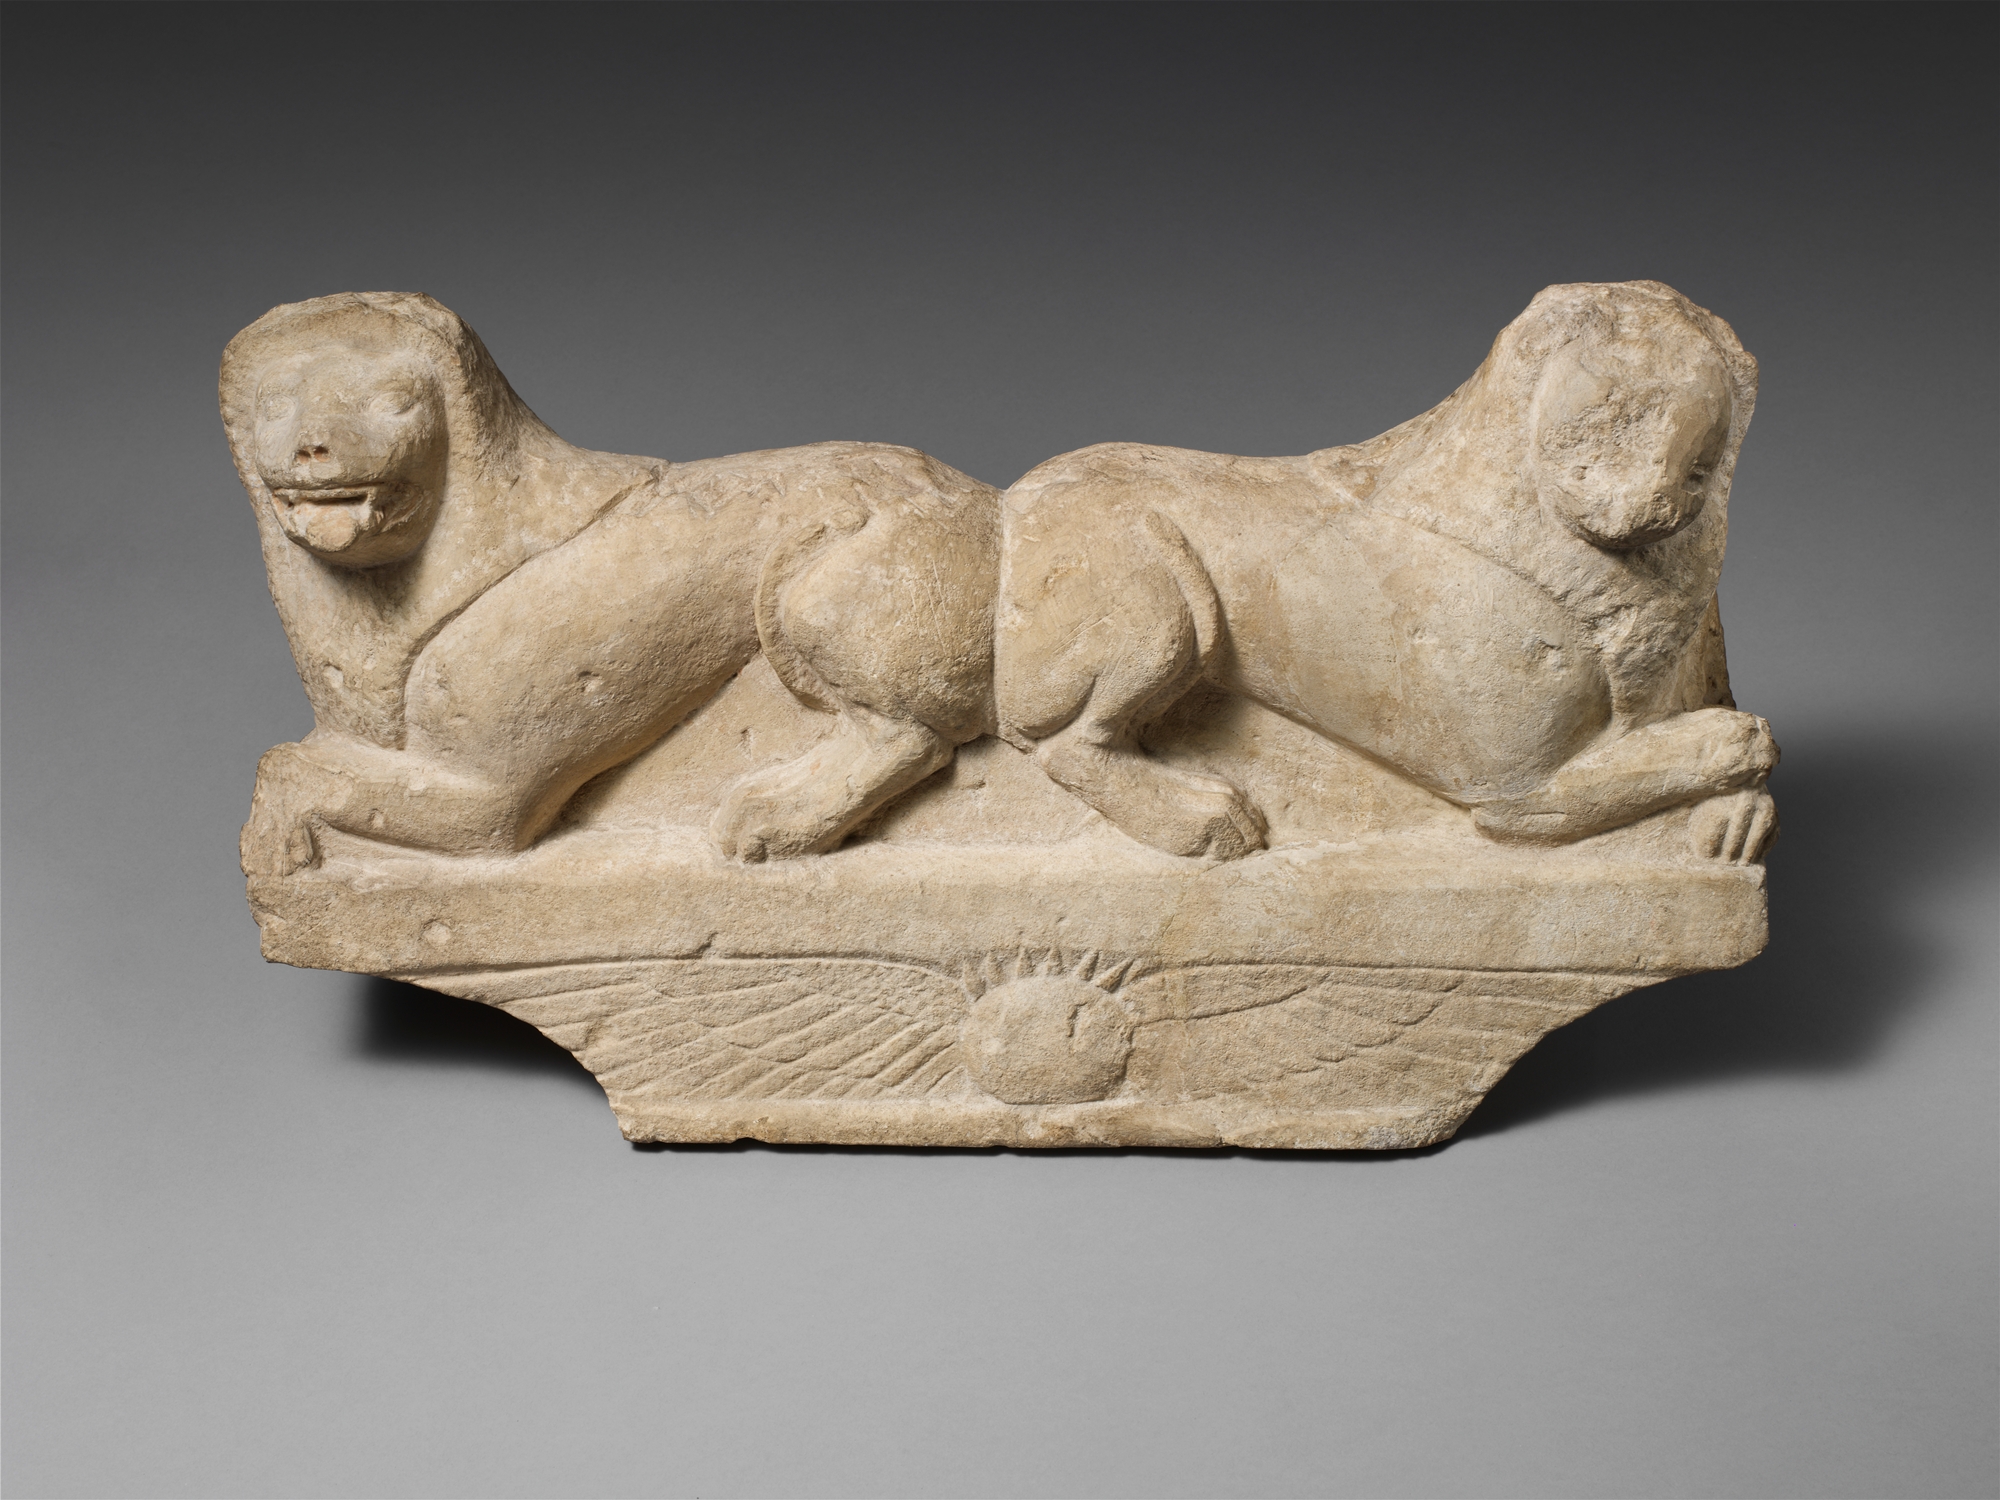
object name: grave stele capital with two lion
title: Limestone finial of a funerary stele with two recumbent lions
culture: cypriot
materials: limestone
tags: lions